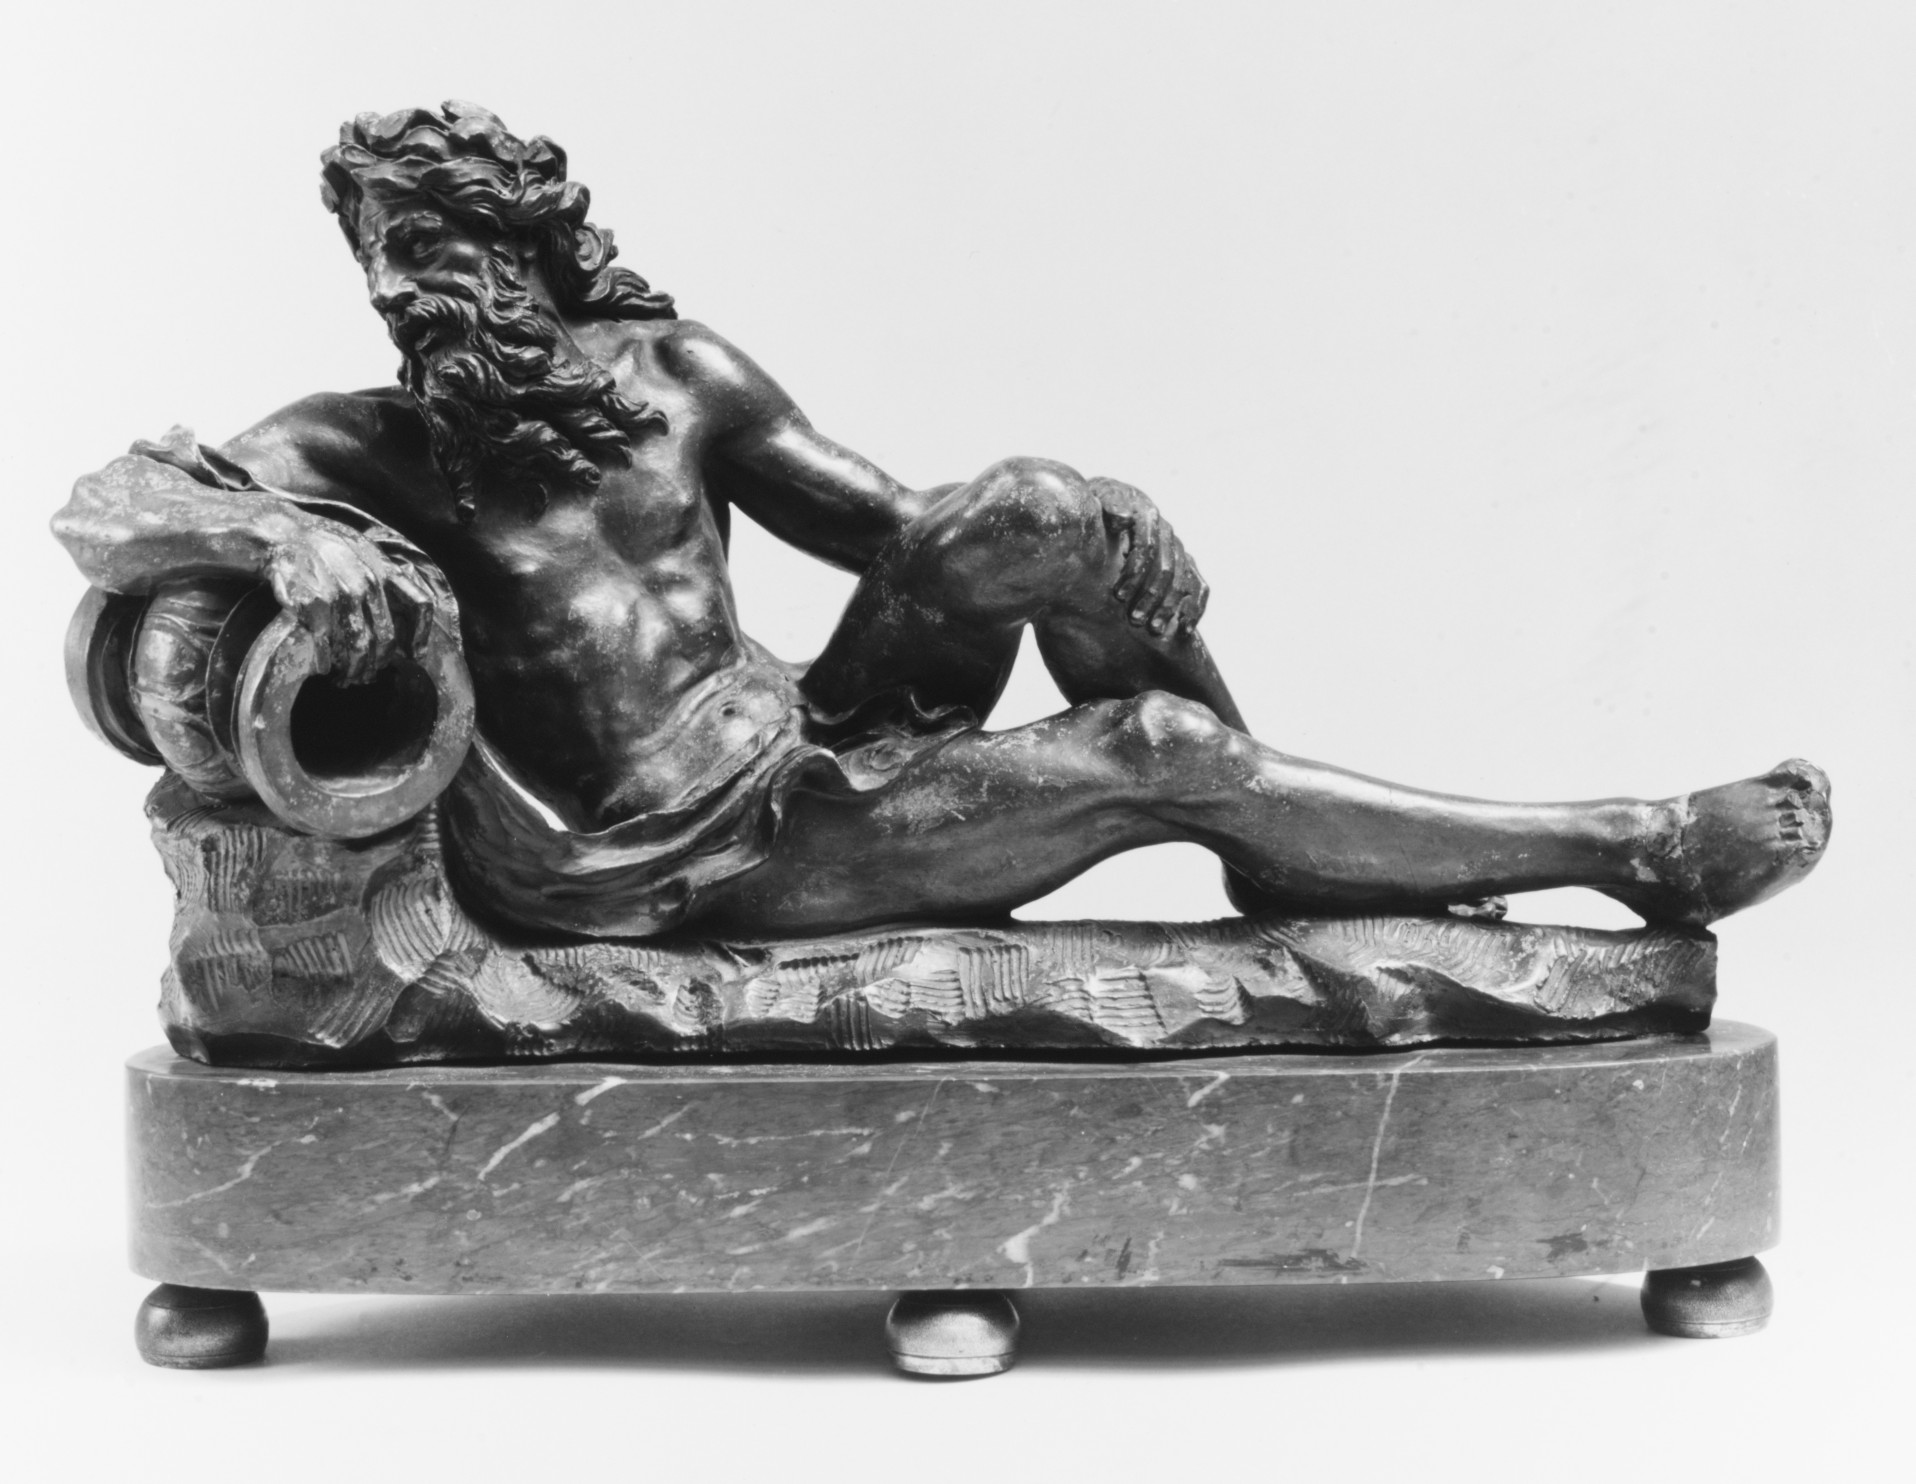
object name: statuette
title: River God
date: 1700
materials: gilt bronze, marble, terracotta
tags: male nudes